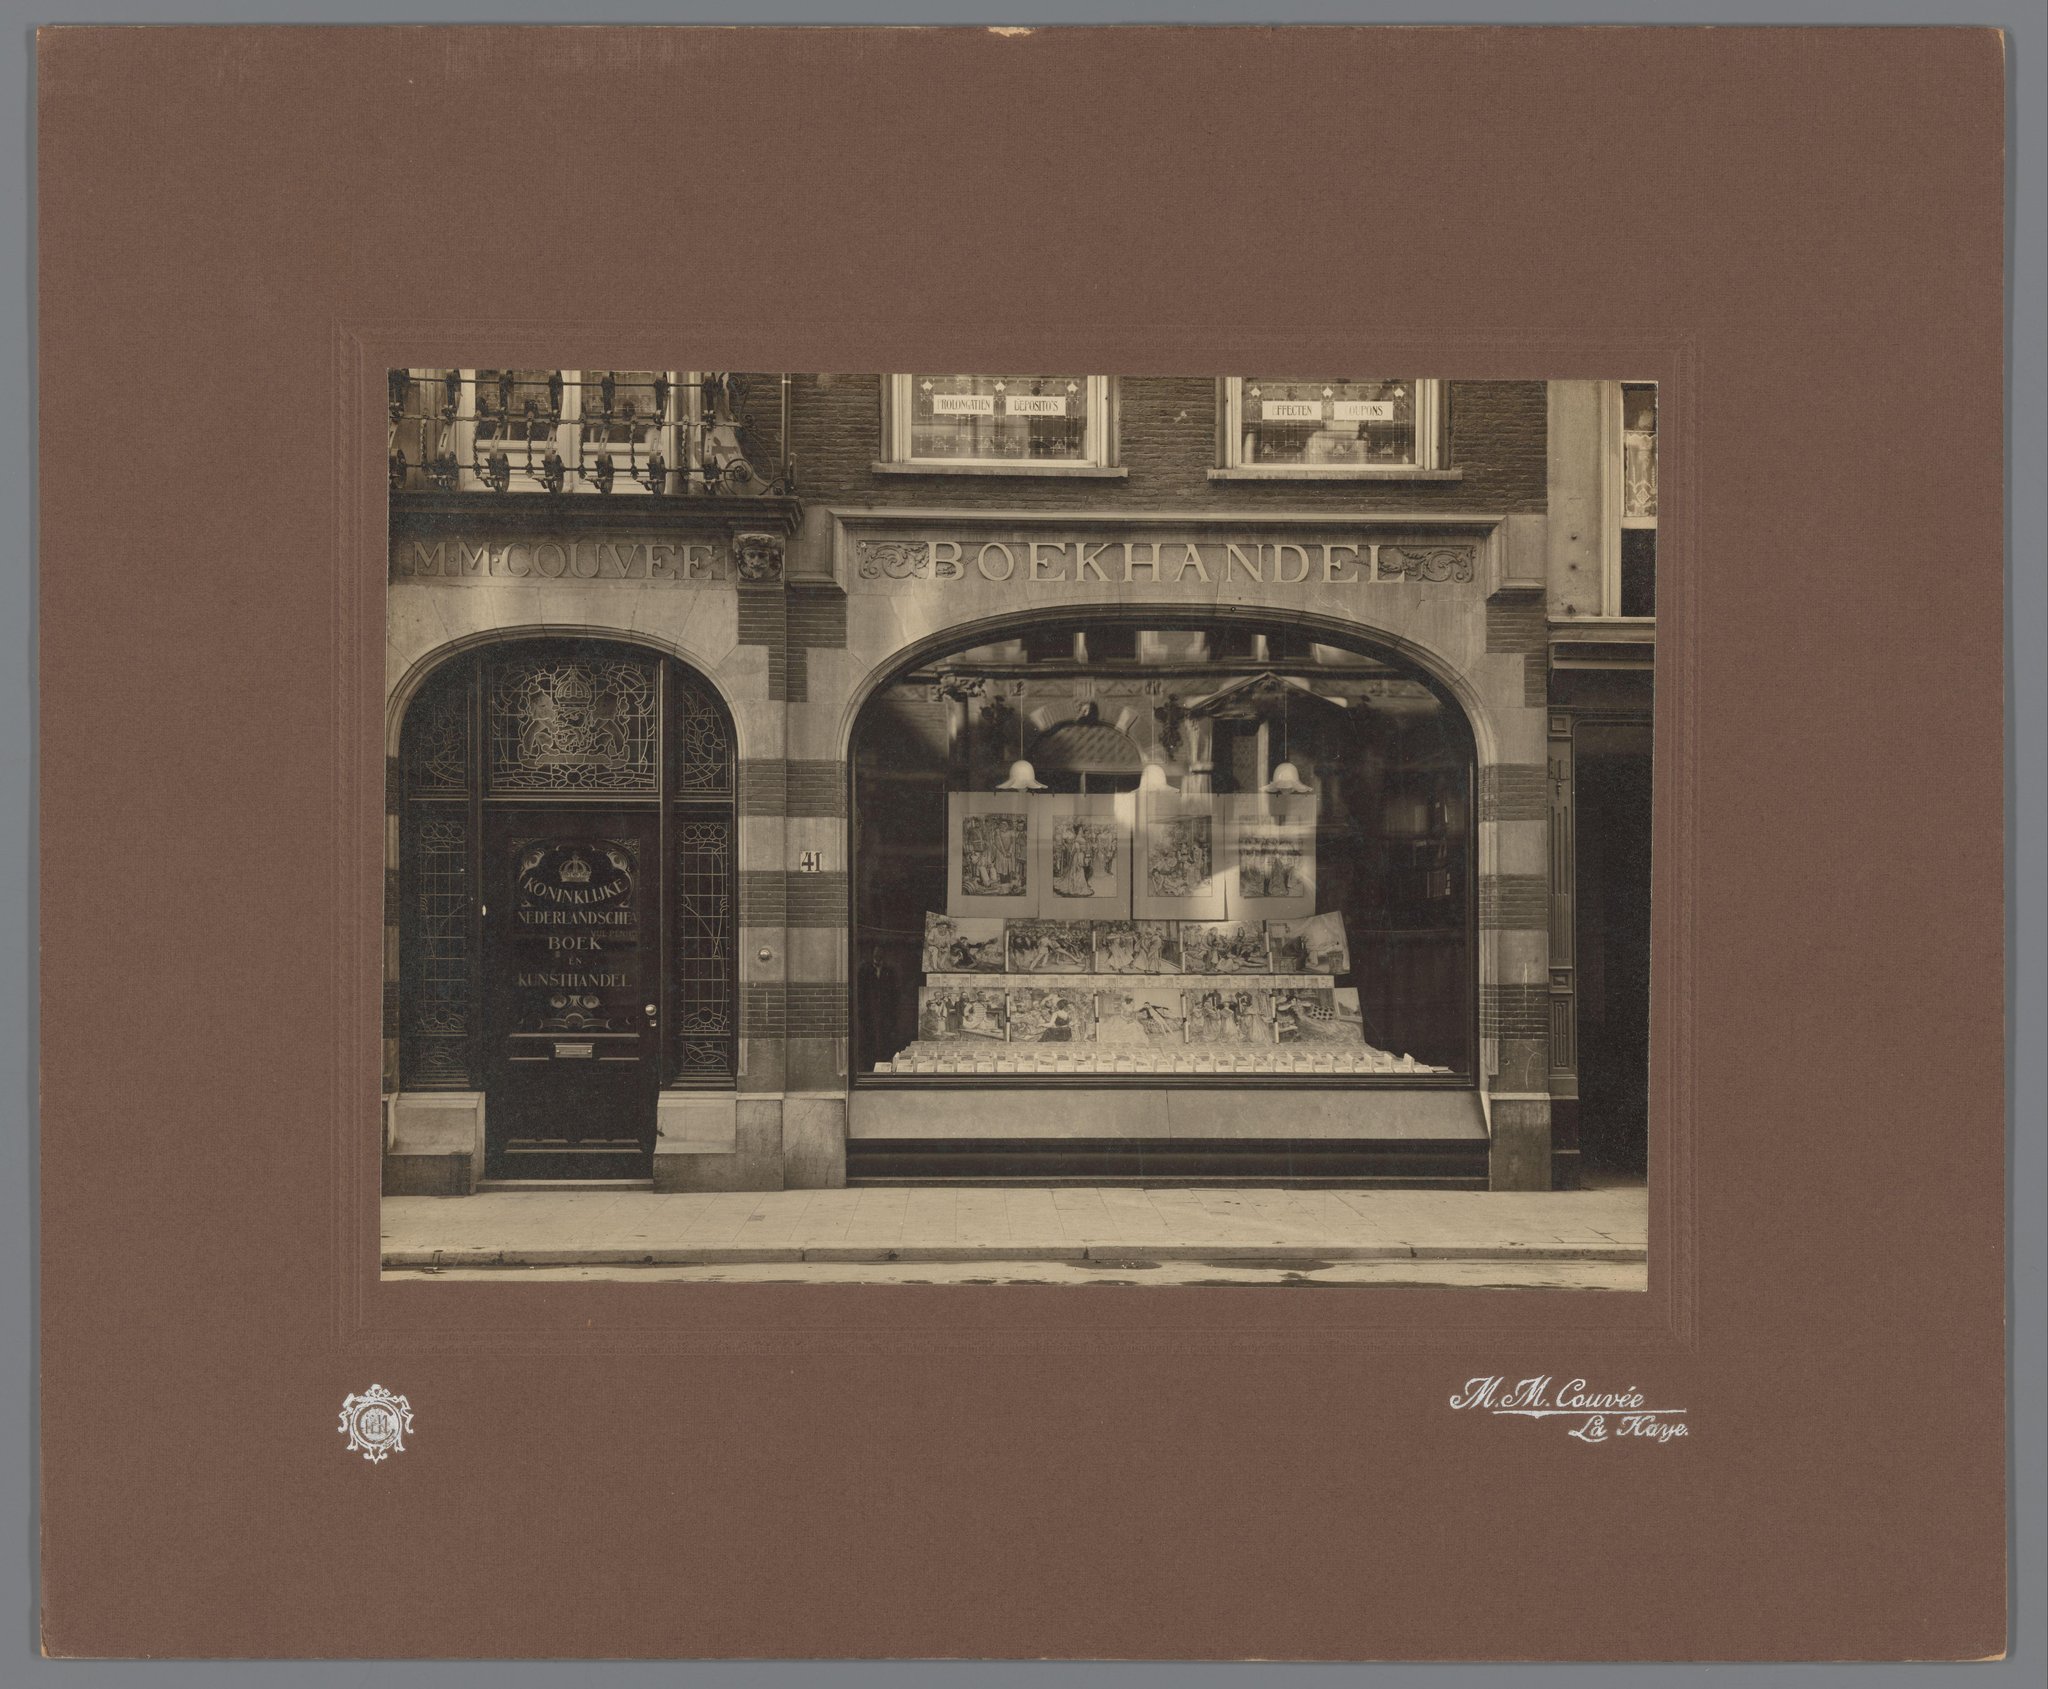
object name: photograph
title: Façade van boekhandel M.M. Couvée te Den Haag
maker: m.m. couvée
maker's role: publisher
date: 1900-1918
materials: cardboard, photographic support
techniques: collodion silver print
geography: the hague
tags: shop, store, the hague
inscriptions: annotation: ‘uit archief Veen/ den Haag/ neg. 22744’, inscription: ‘M.M. Couvée/ La Haye’